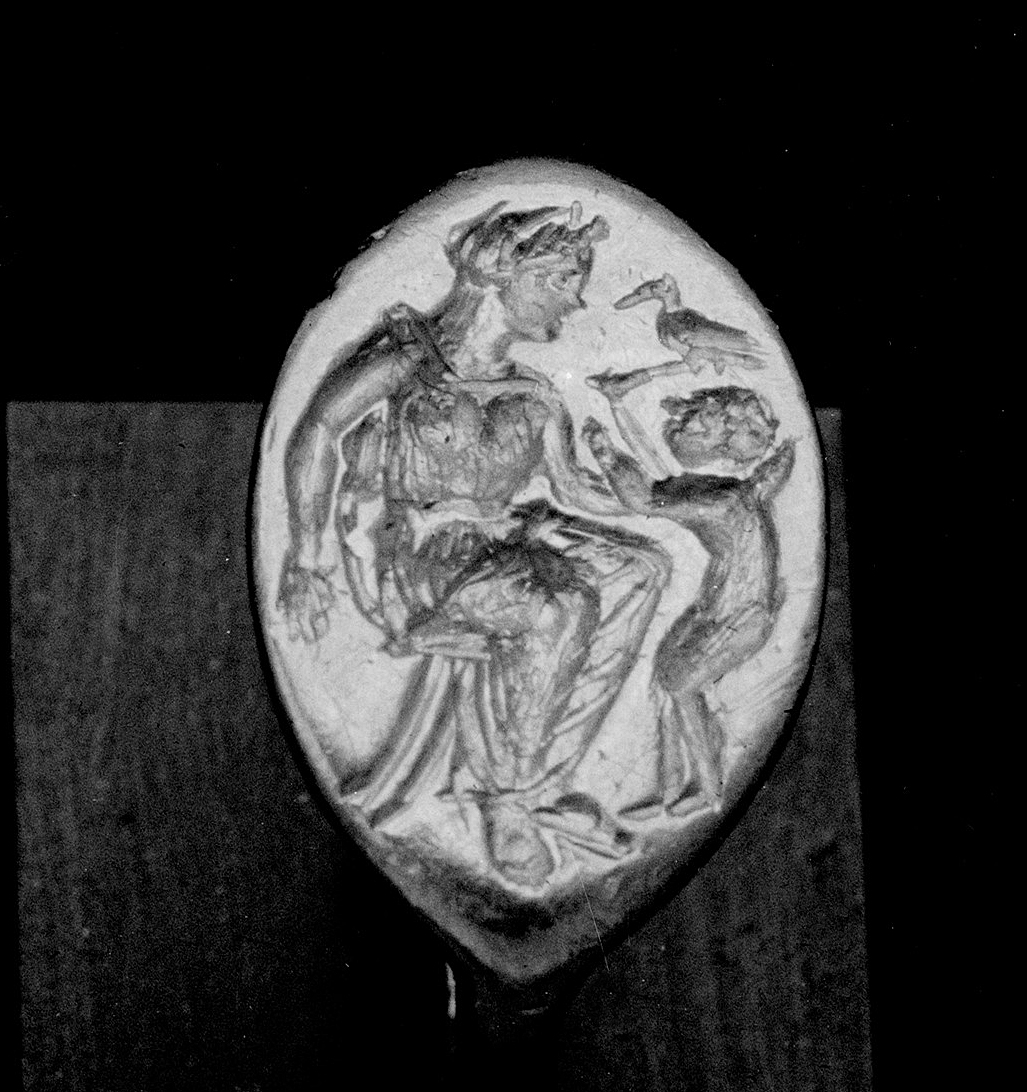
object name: ring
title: Gold ring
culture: greek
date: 450-426 BCE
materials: gold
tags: birds,women,eros